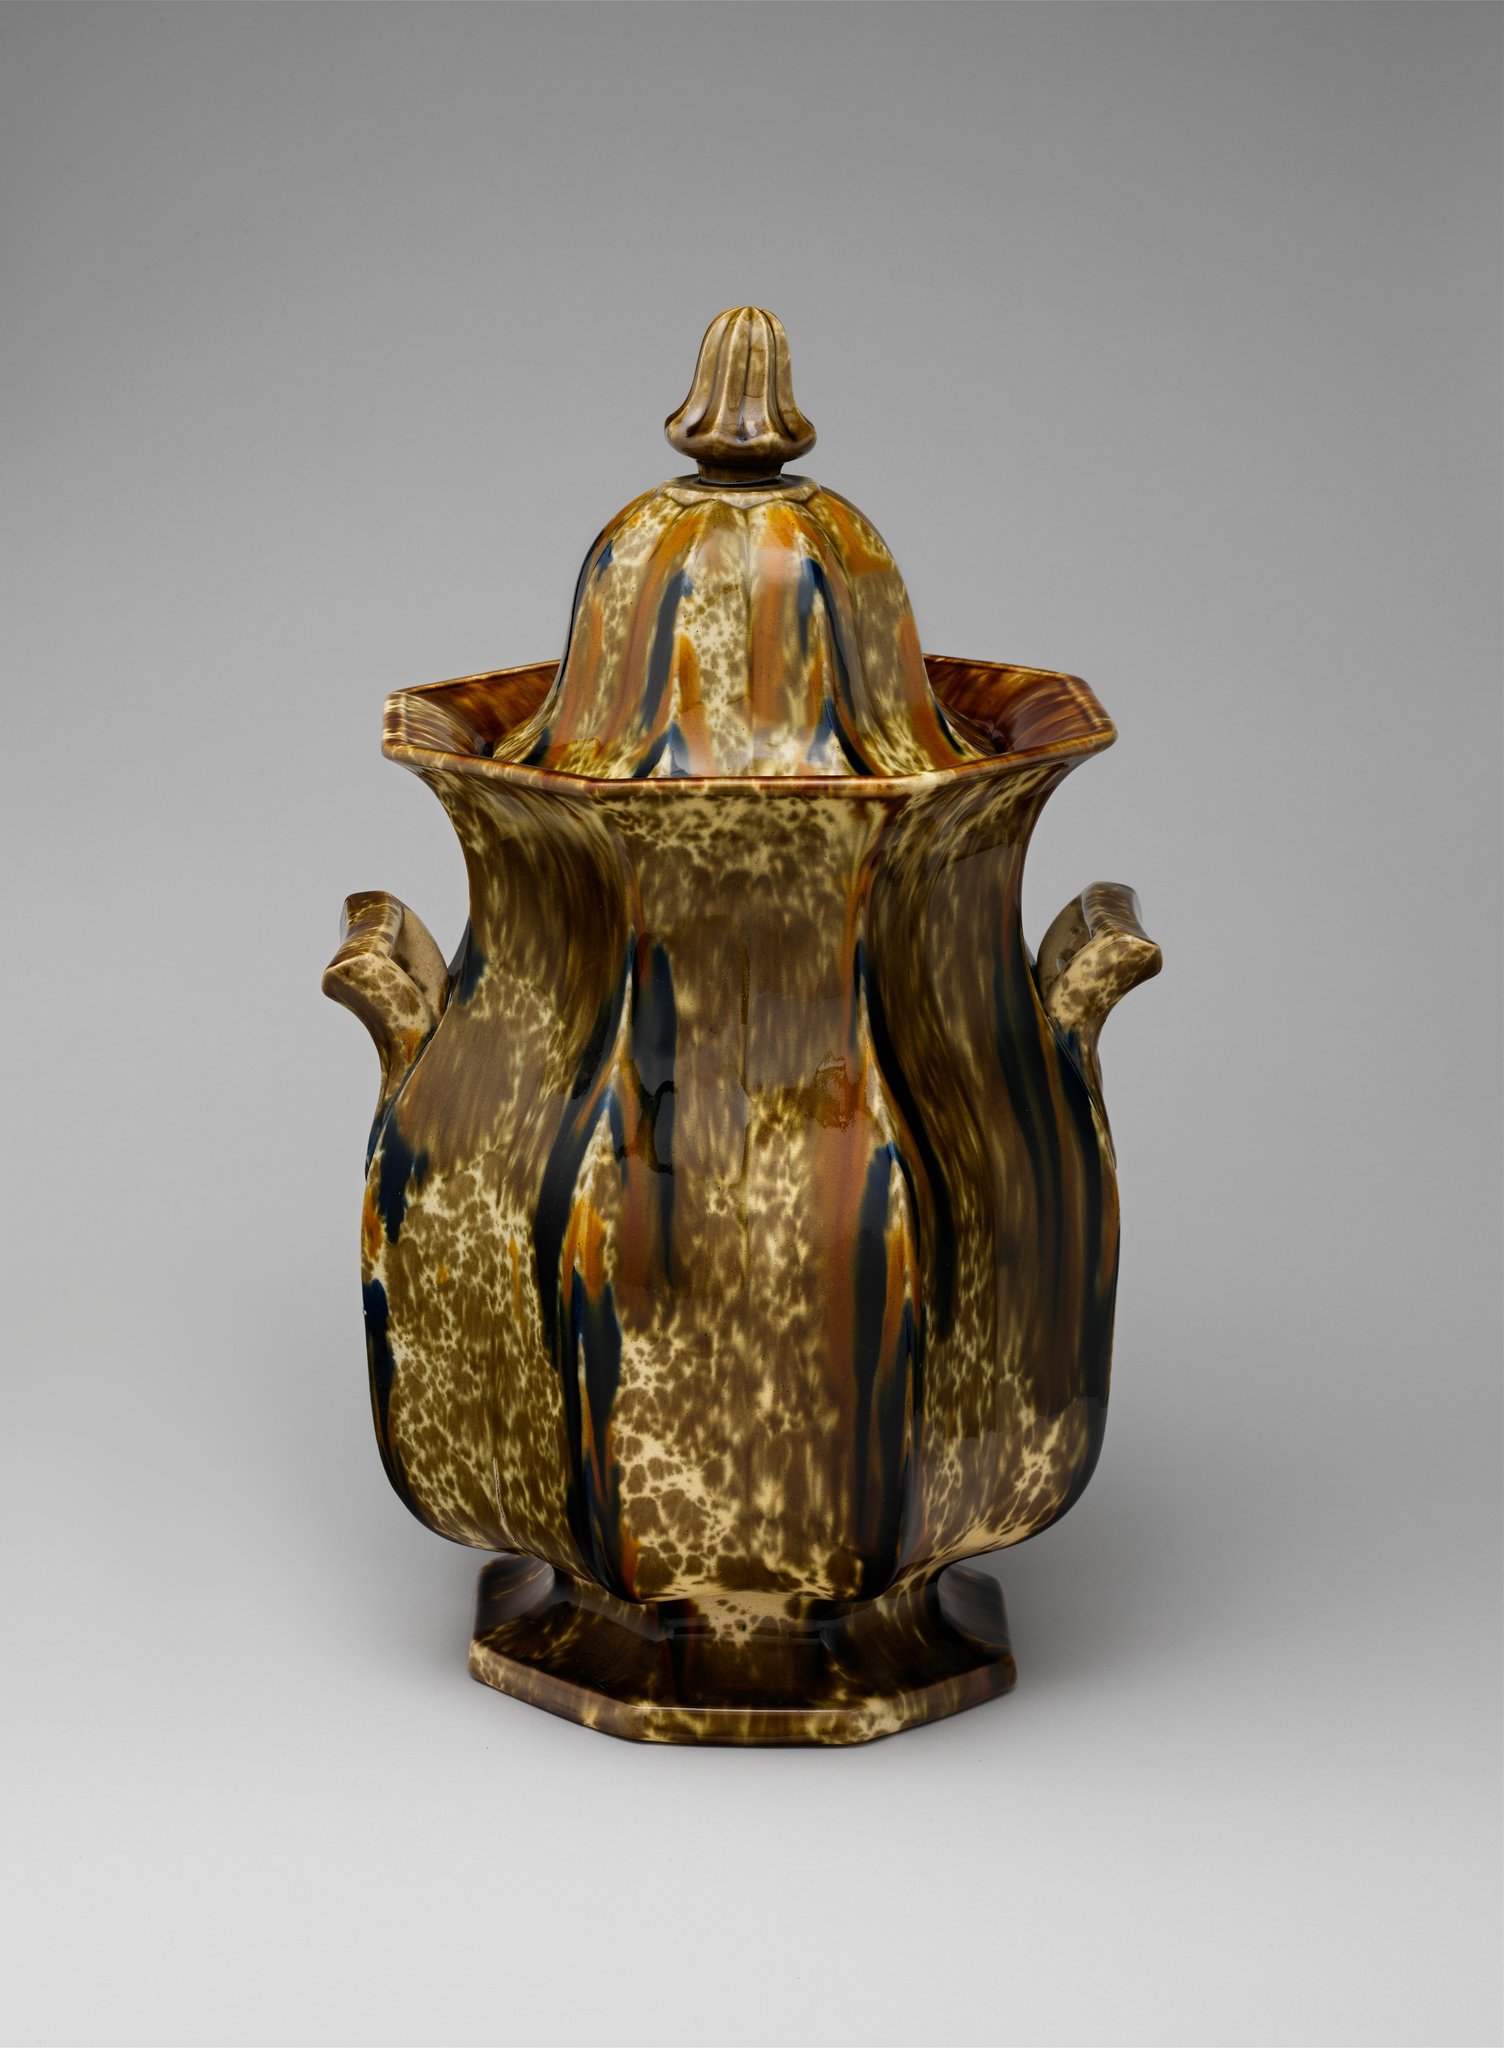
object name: slop jar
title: Covered slop jar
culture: american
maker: united states pottery company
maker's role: maker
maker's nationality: american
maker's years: 1852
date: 1849-1858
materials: earthenware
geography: united states